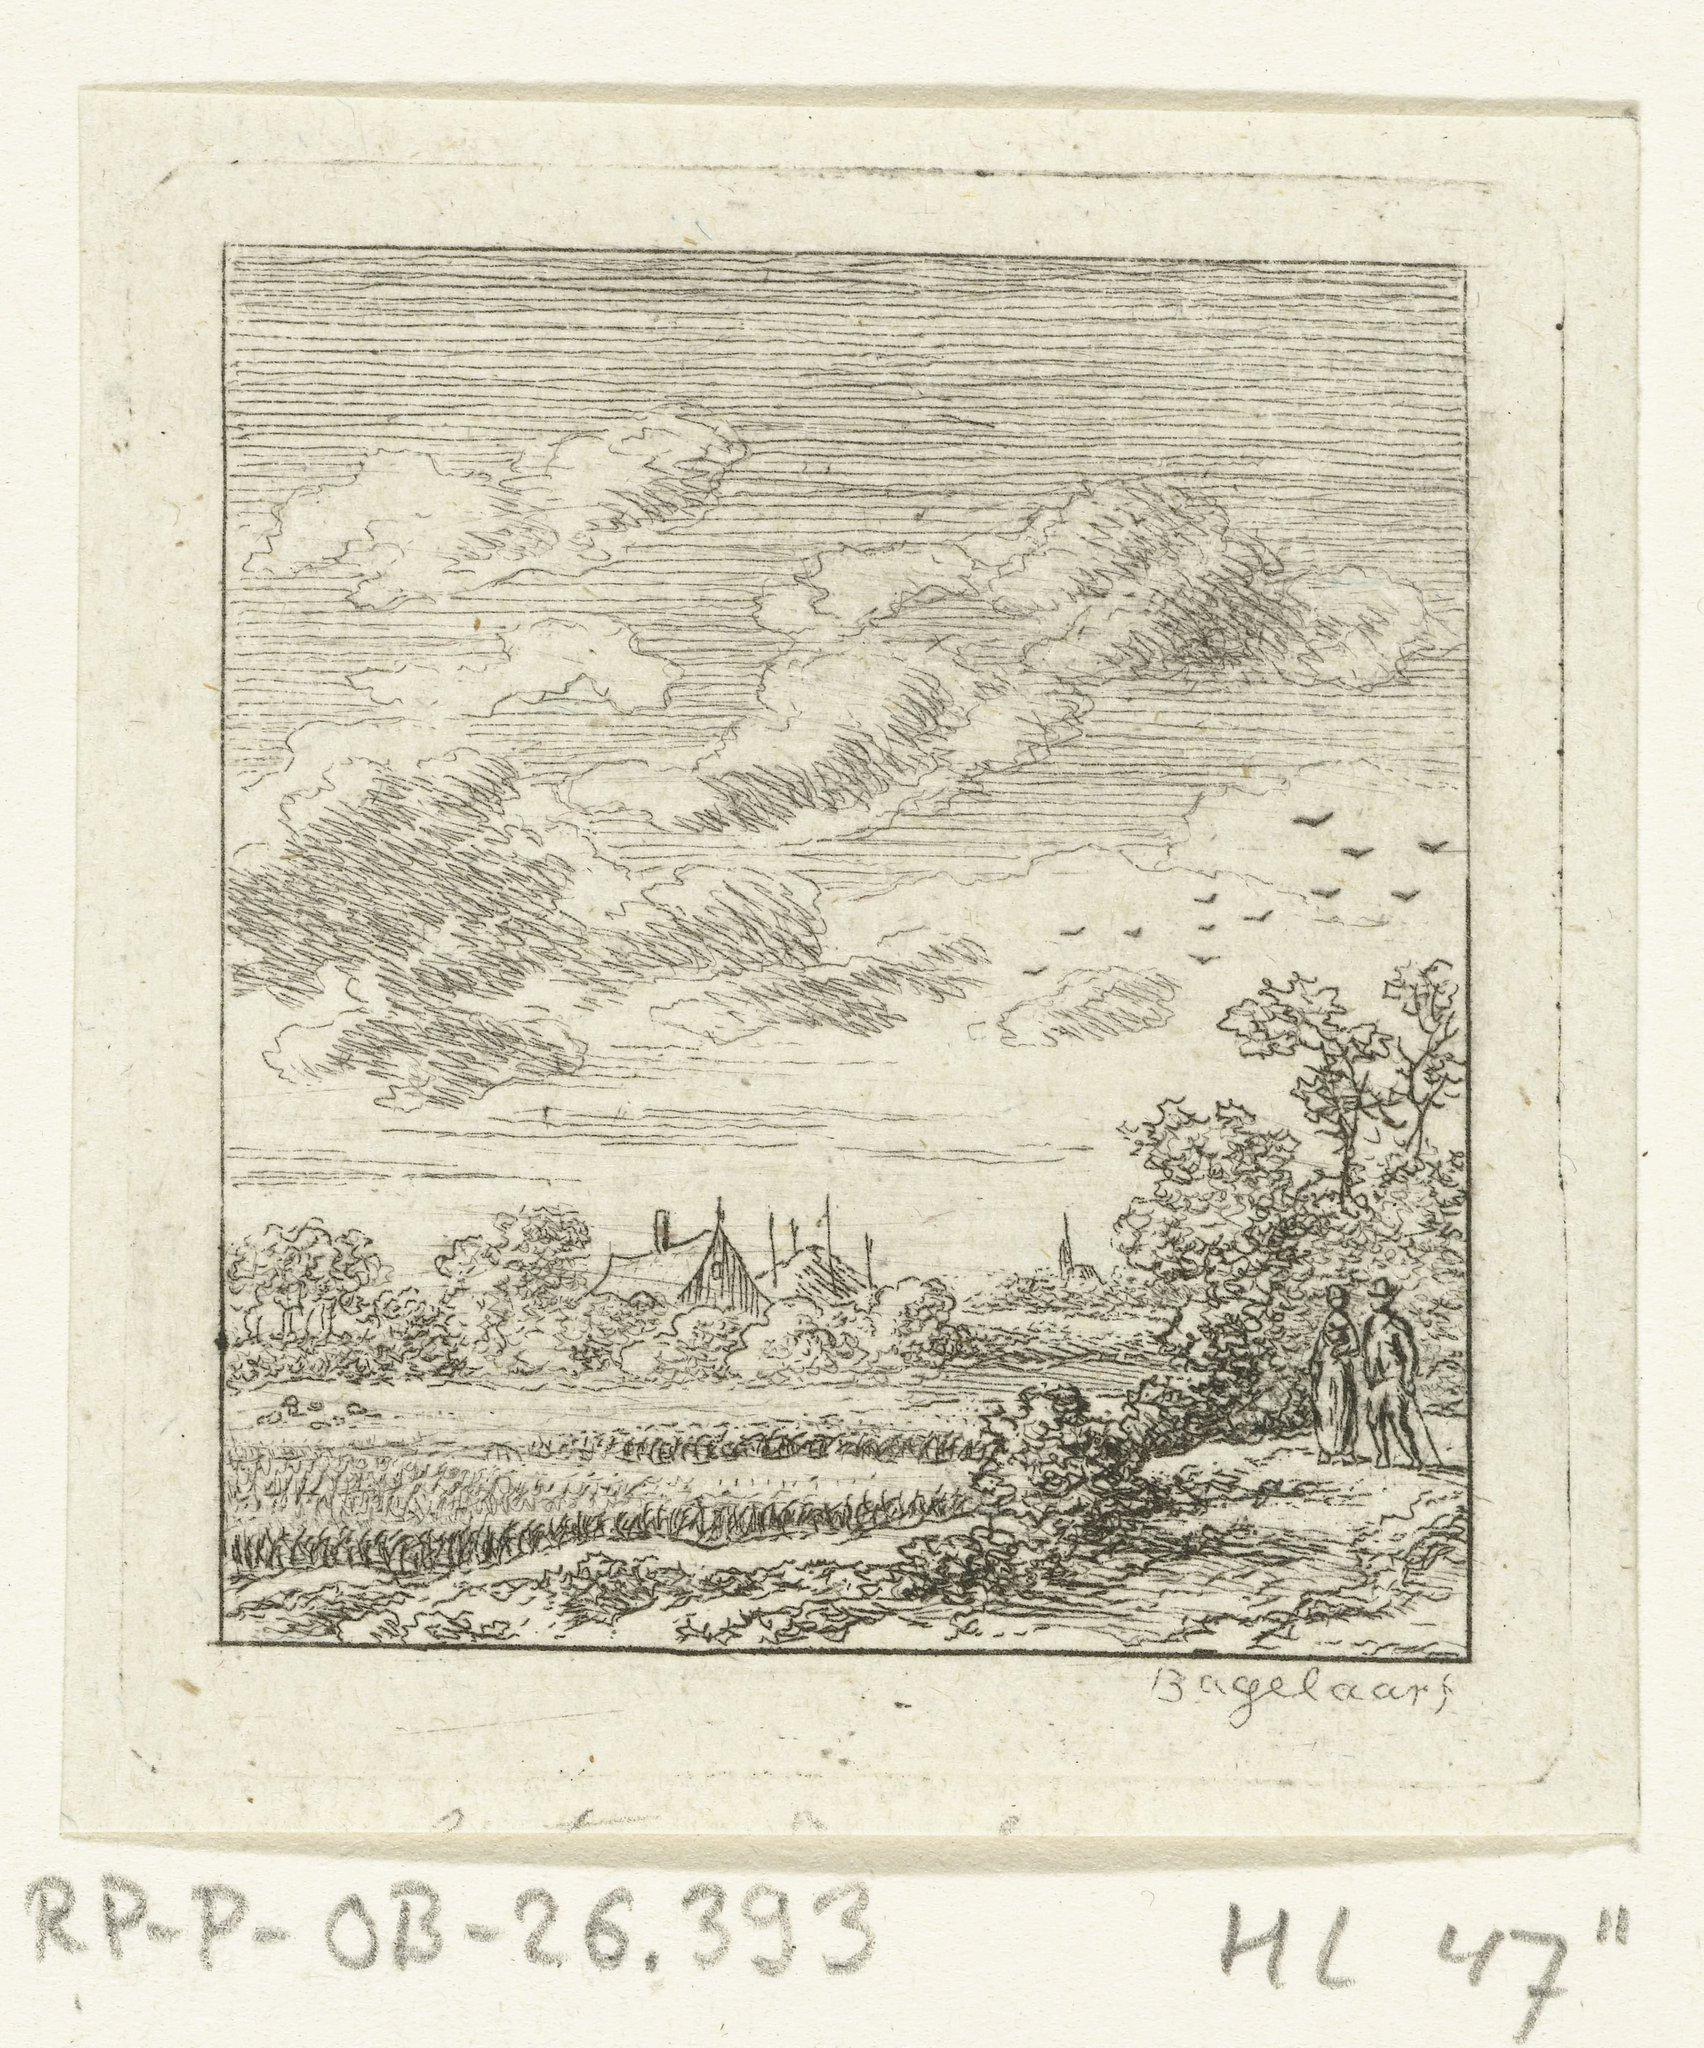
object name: print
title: Landschap met wandelend stel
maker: ernst willem jan bagelaar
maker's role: draughtsman, print maker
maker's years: 1775-1837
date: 1798-1837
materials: paper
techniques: etching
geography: netherlands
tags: landscapes in the temperate zone